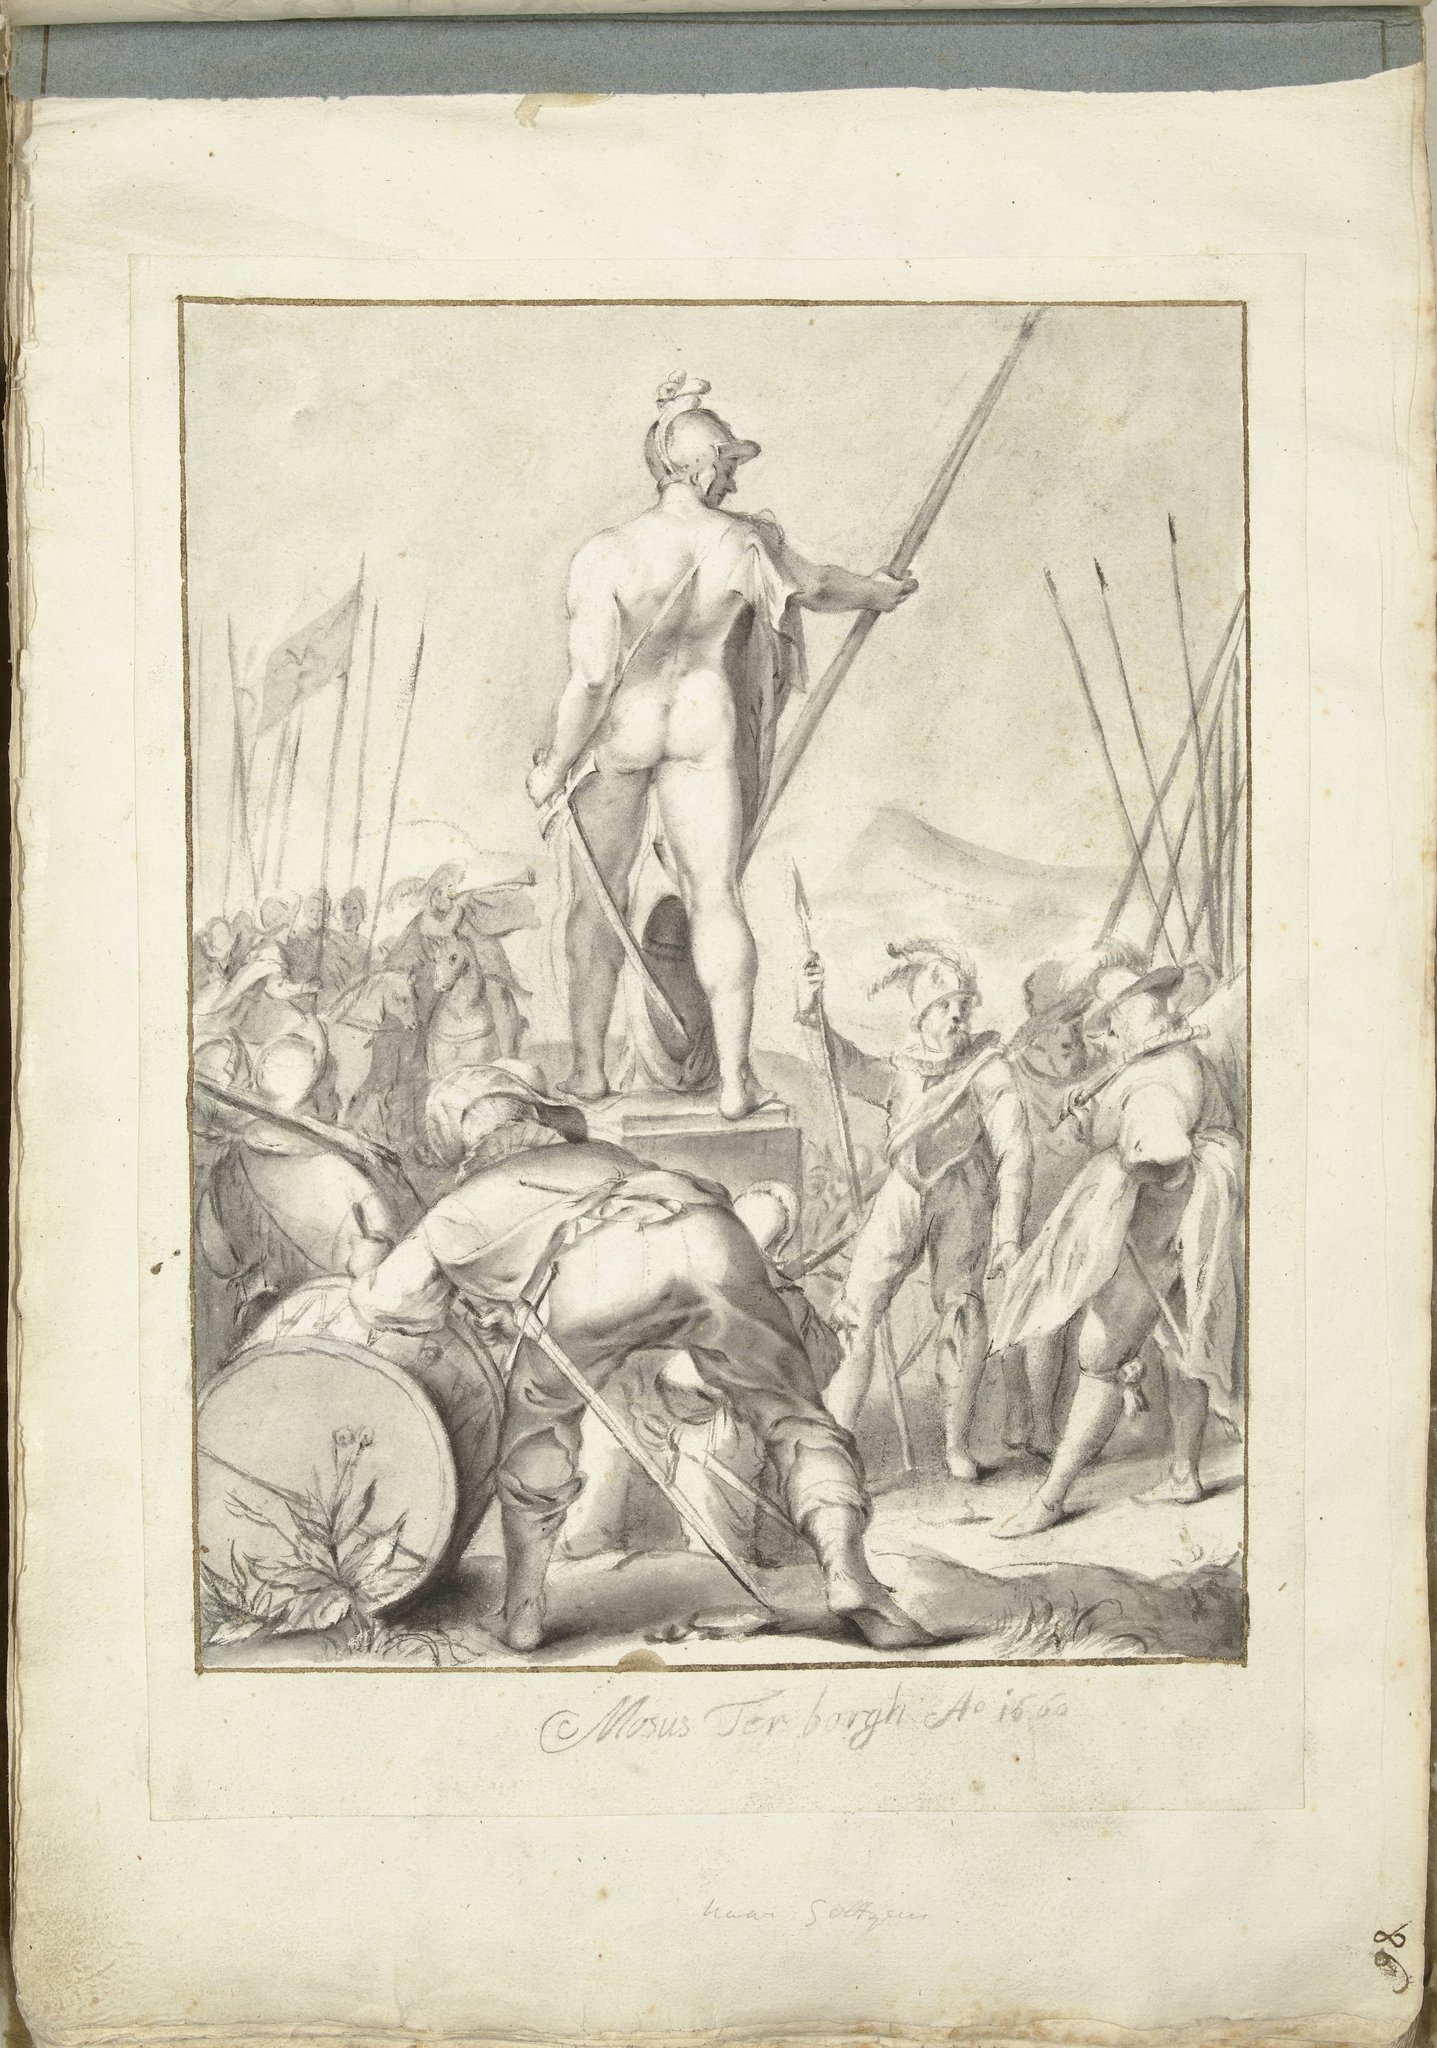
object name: drawing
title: Mars, god van de oorlogskunsten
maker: moses ter borch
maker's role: draughtsman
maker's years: 1645-1667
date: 1660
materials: chalk, ink, paper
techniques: brush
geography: zwolle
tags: moses ter borch, raid on the medway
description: Tekening opgeplakt op een blad dat bevestigd is aan een blauwe reep ingebonden papier.